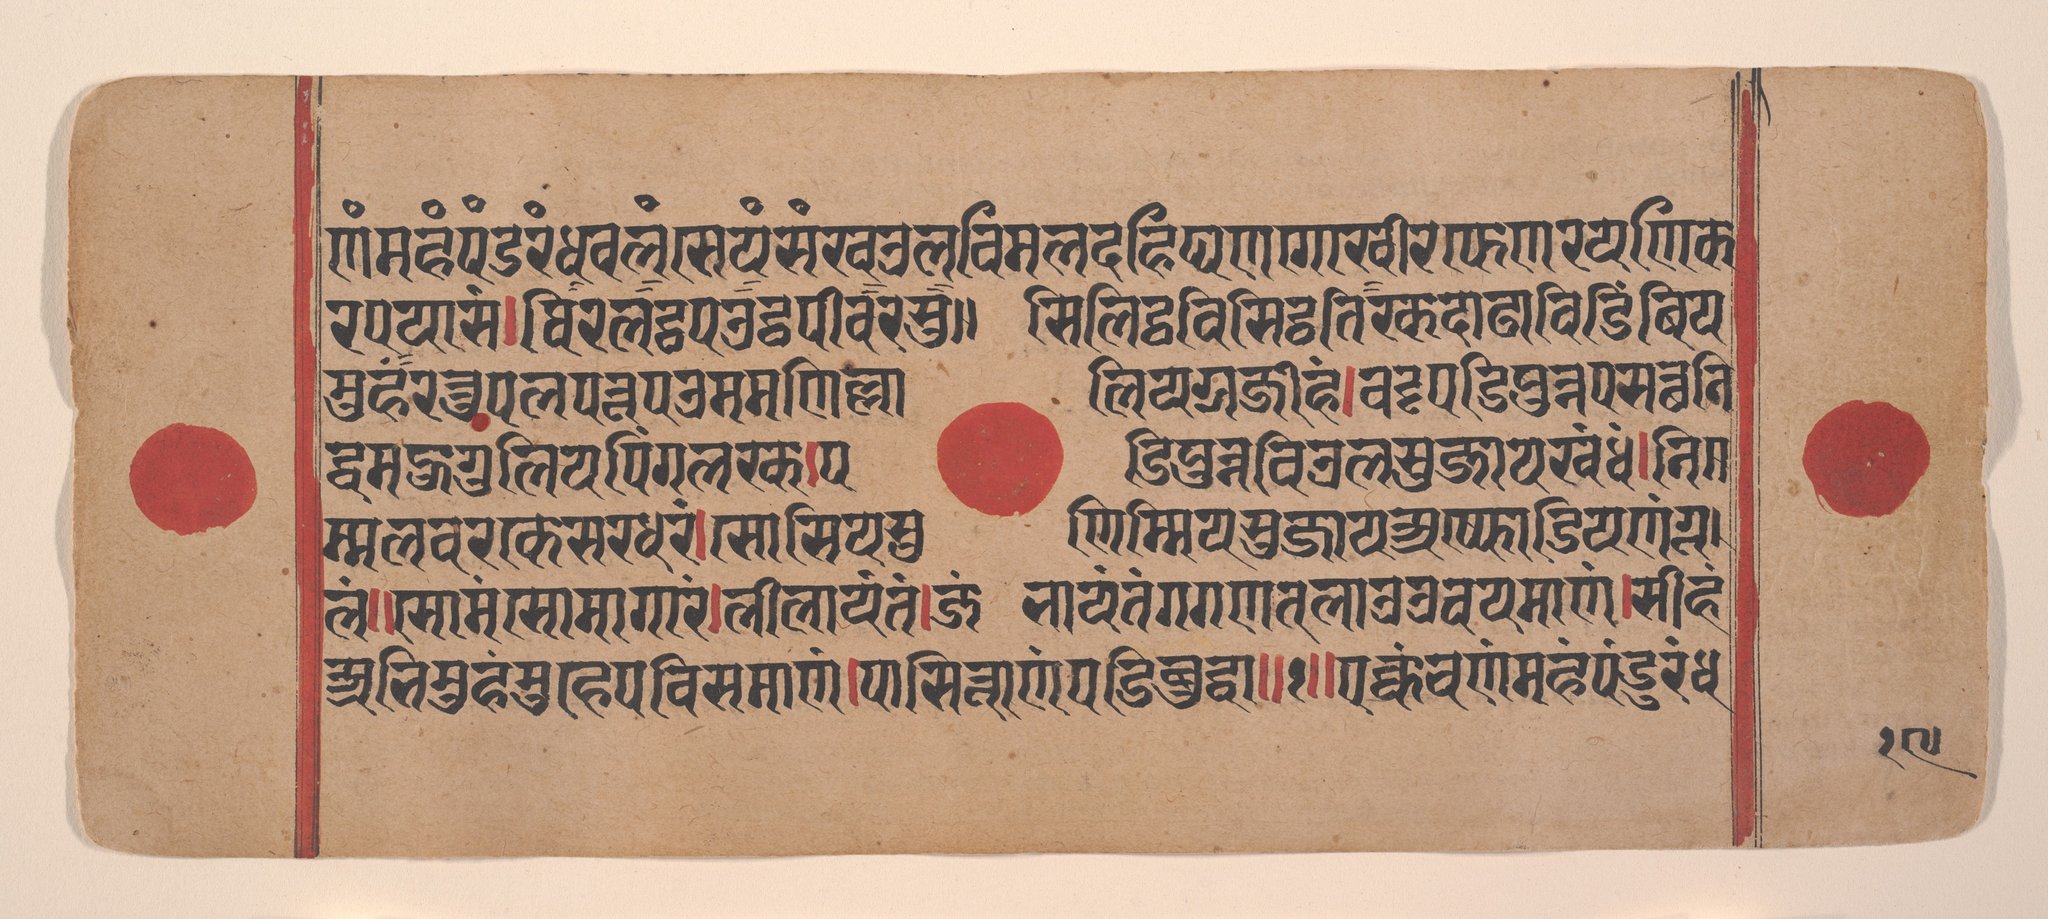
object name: folio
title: Page from a Dispersed Kalpa Sutra (Jain Book of Rituals)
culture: indian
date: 1401-1500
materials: gold, ink, paper, watercolor